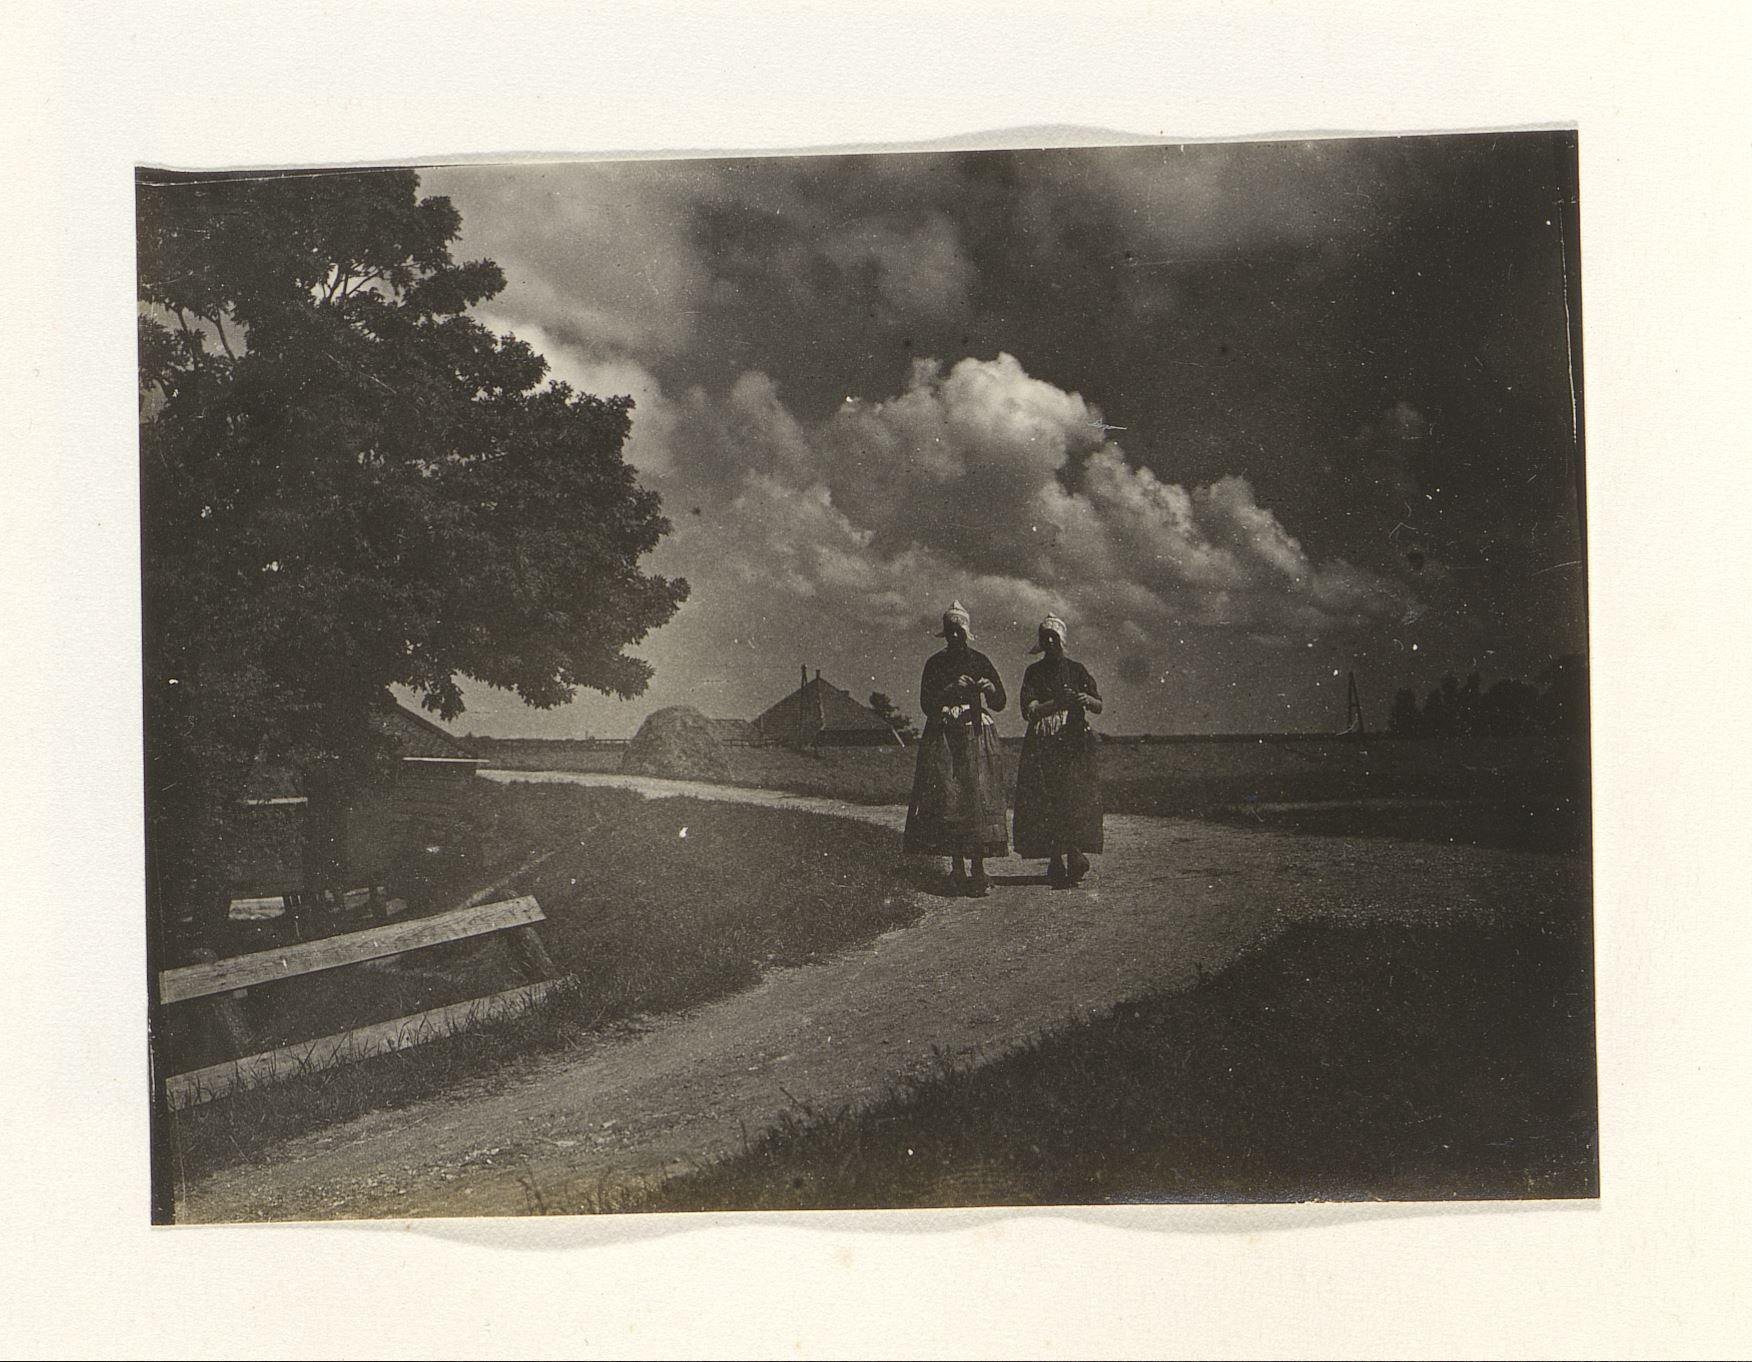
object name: photograph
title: Twee vrouwen in klederdracht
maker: george hidderley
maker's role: fotograaf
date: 1900-1910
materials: paper, photographic support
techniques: gelatin silver print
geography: volendam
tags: adult woman, historical persons, folk costume, regional costume